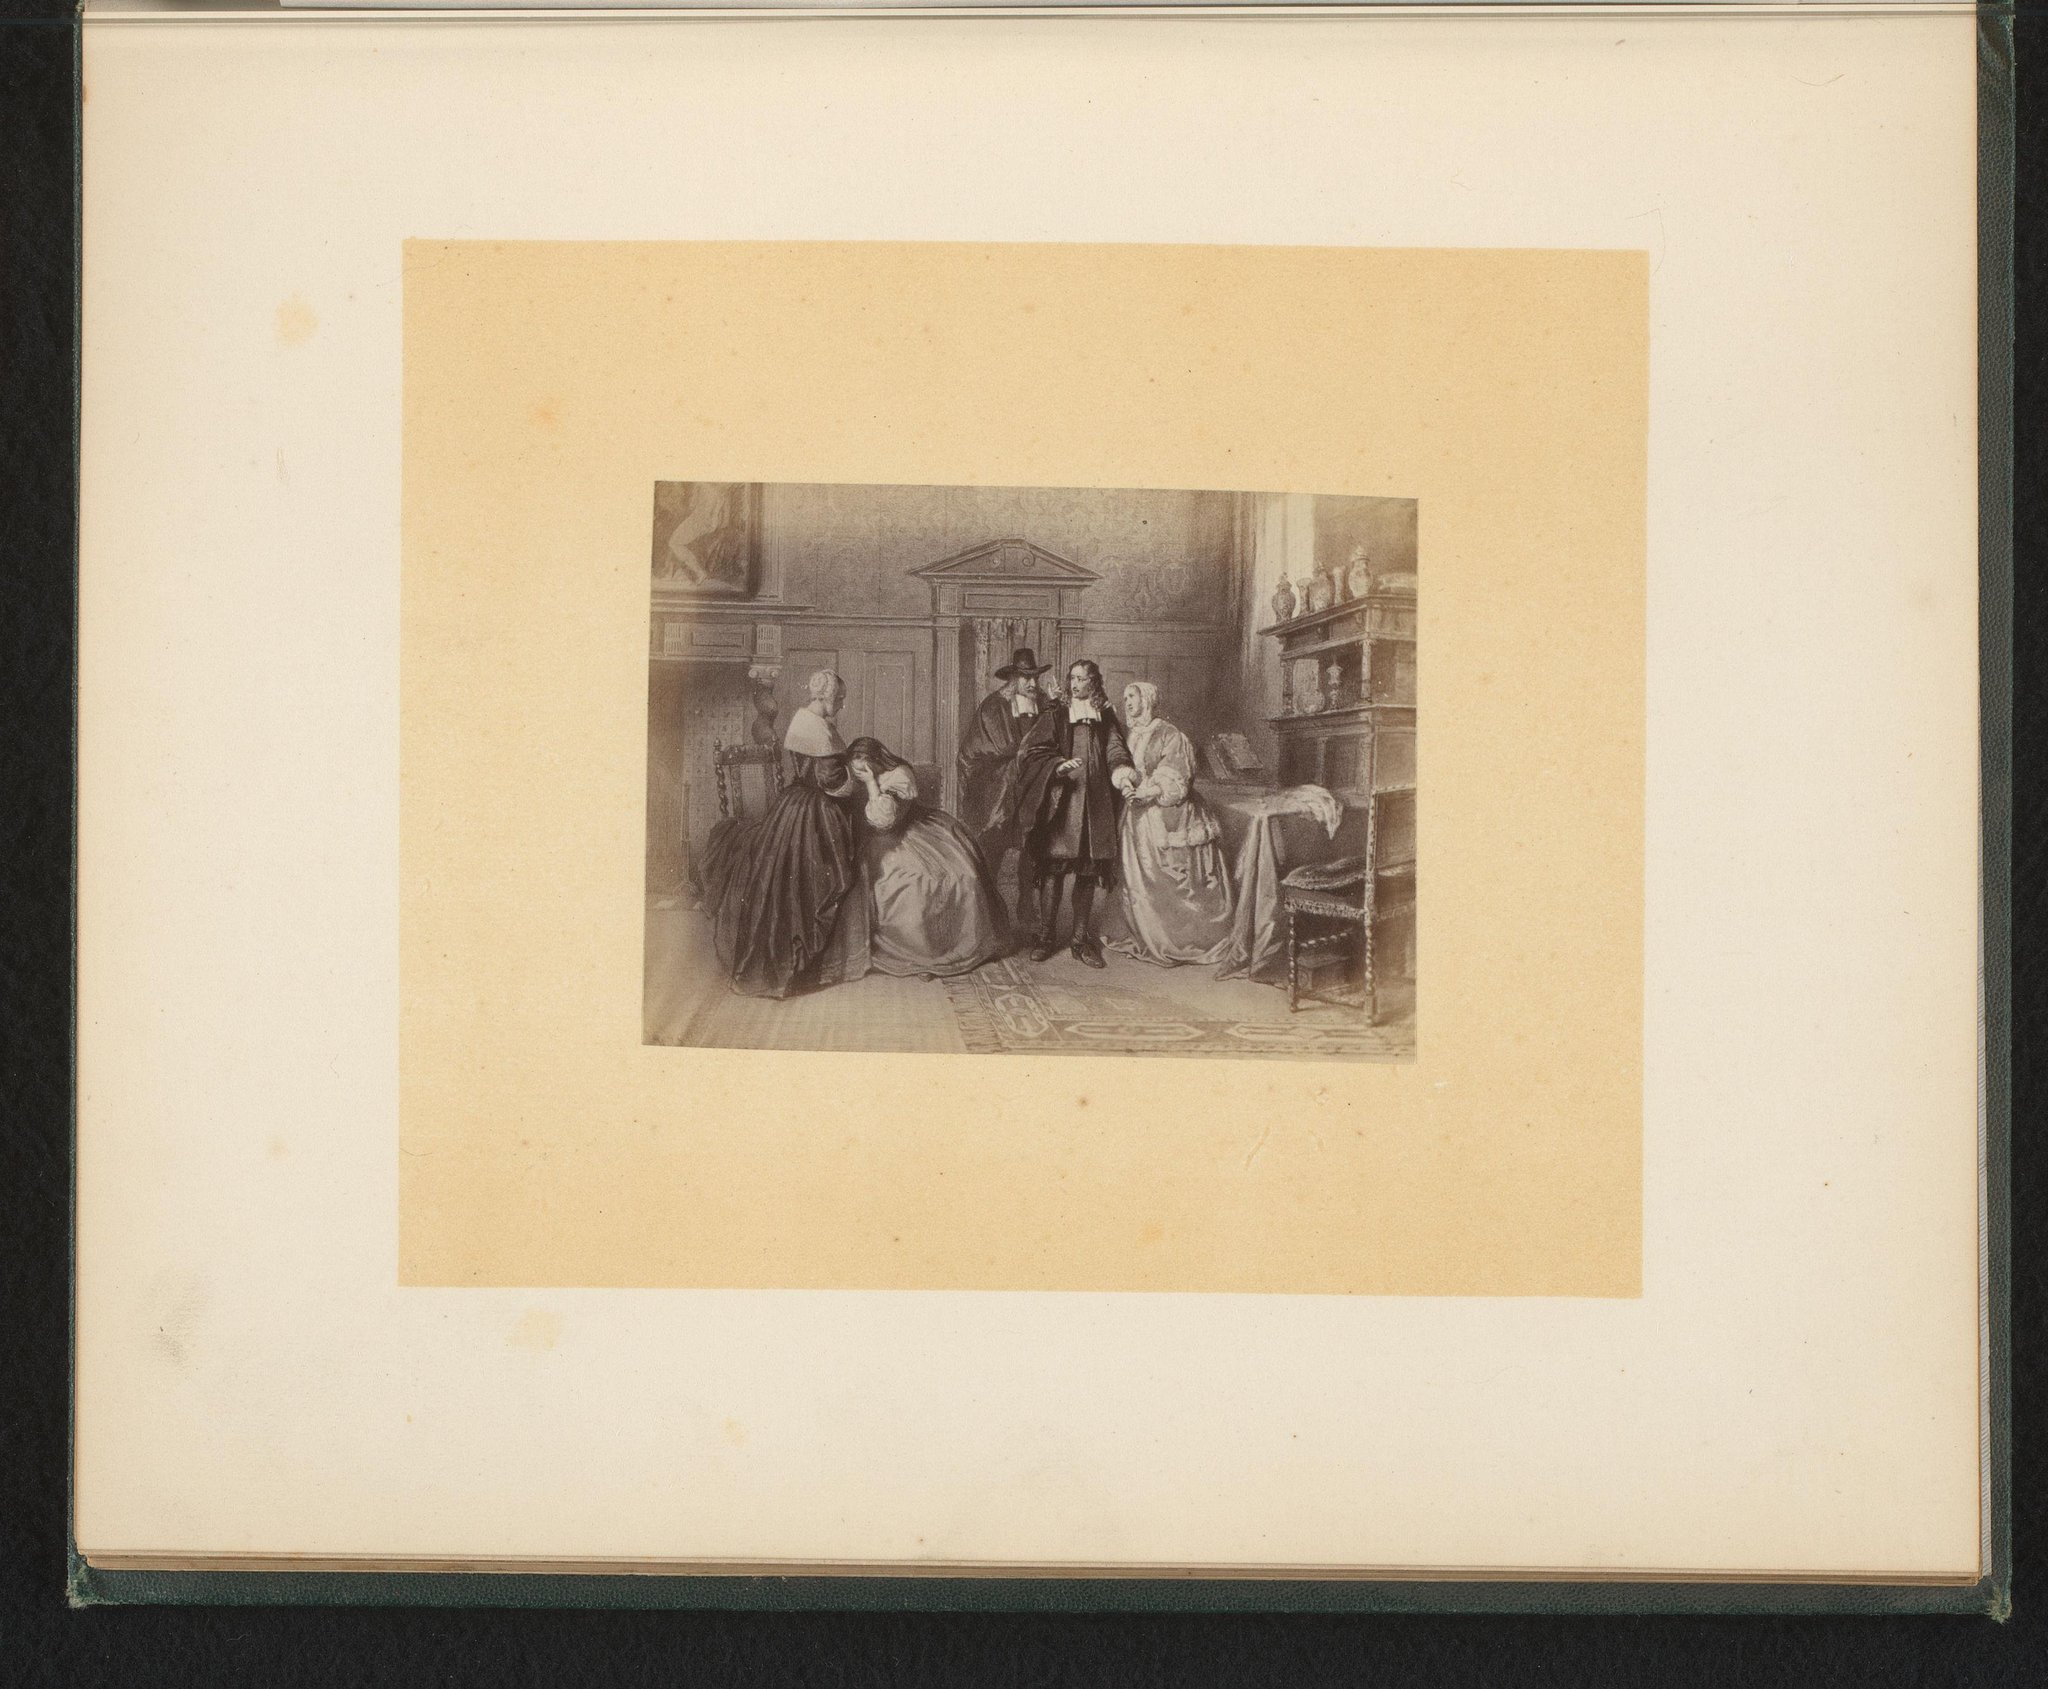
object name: photograph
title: Fotoreproductie schilderij ter illustratie van Van Lenneps Elisabeth Muschen door Hendrik Jacobus Scholten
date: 1870-1880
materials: paper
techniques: albumen print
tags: picture, painting